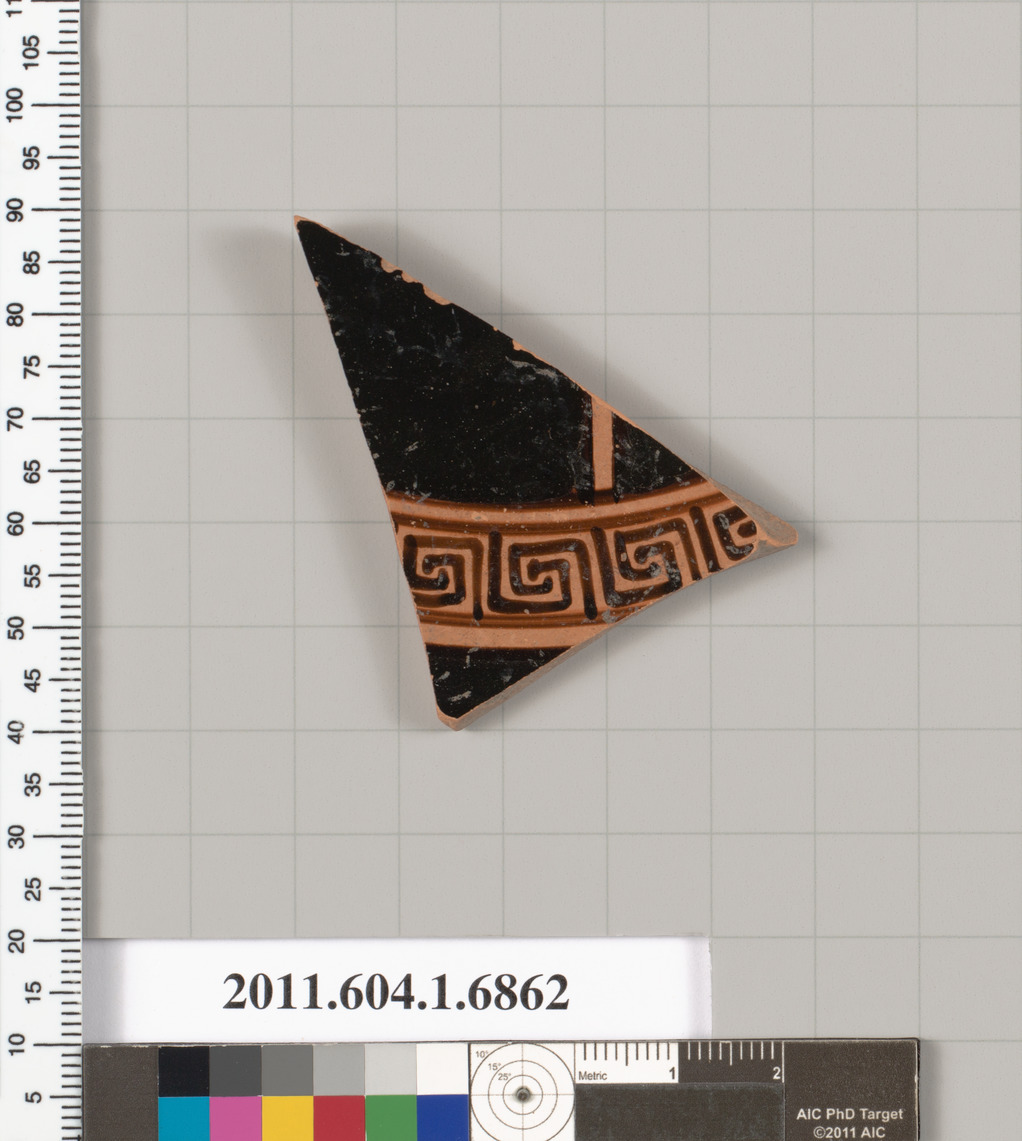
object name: kylix fragment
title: Terracotta fragment of a kylix (drinking cup)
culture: greek, attic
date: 490-470 BCE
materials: terracotta